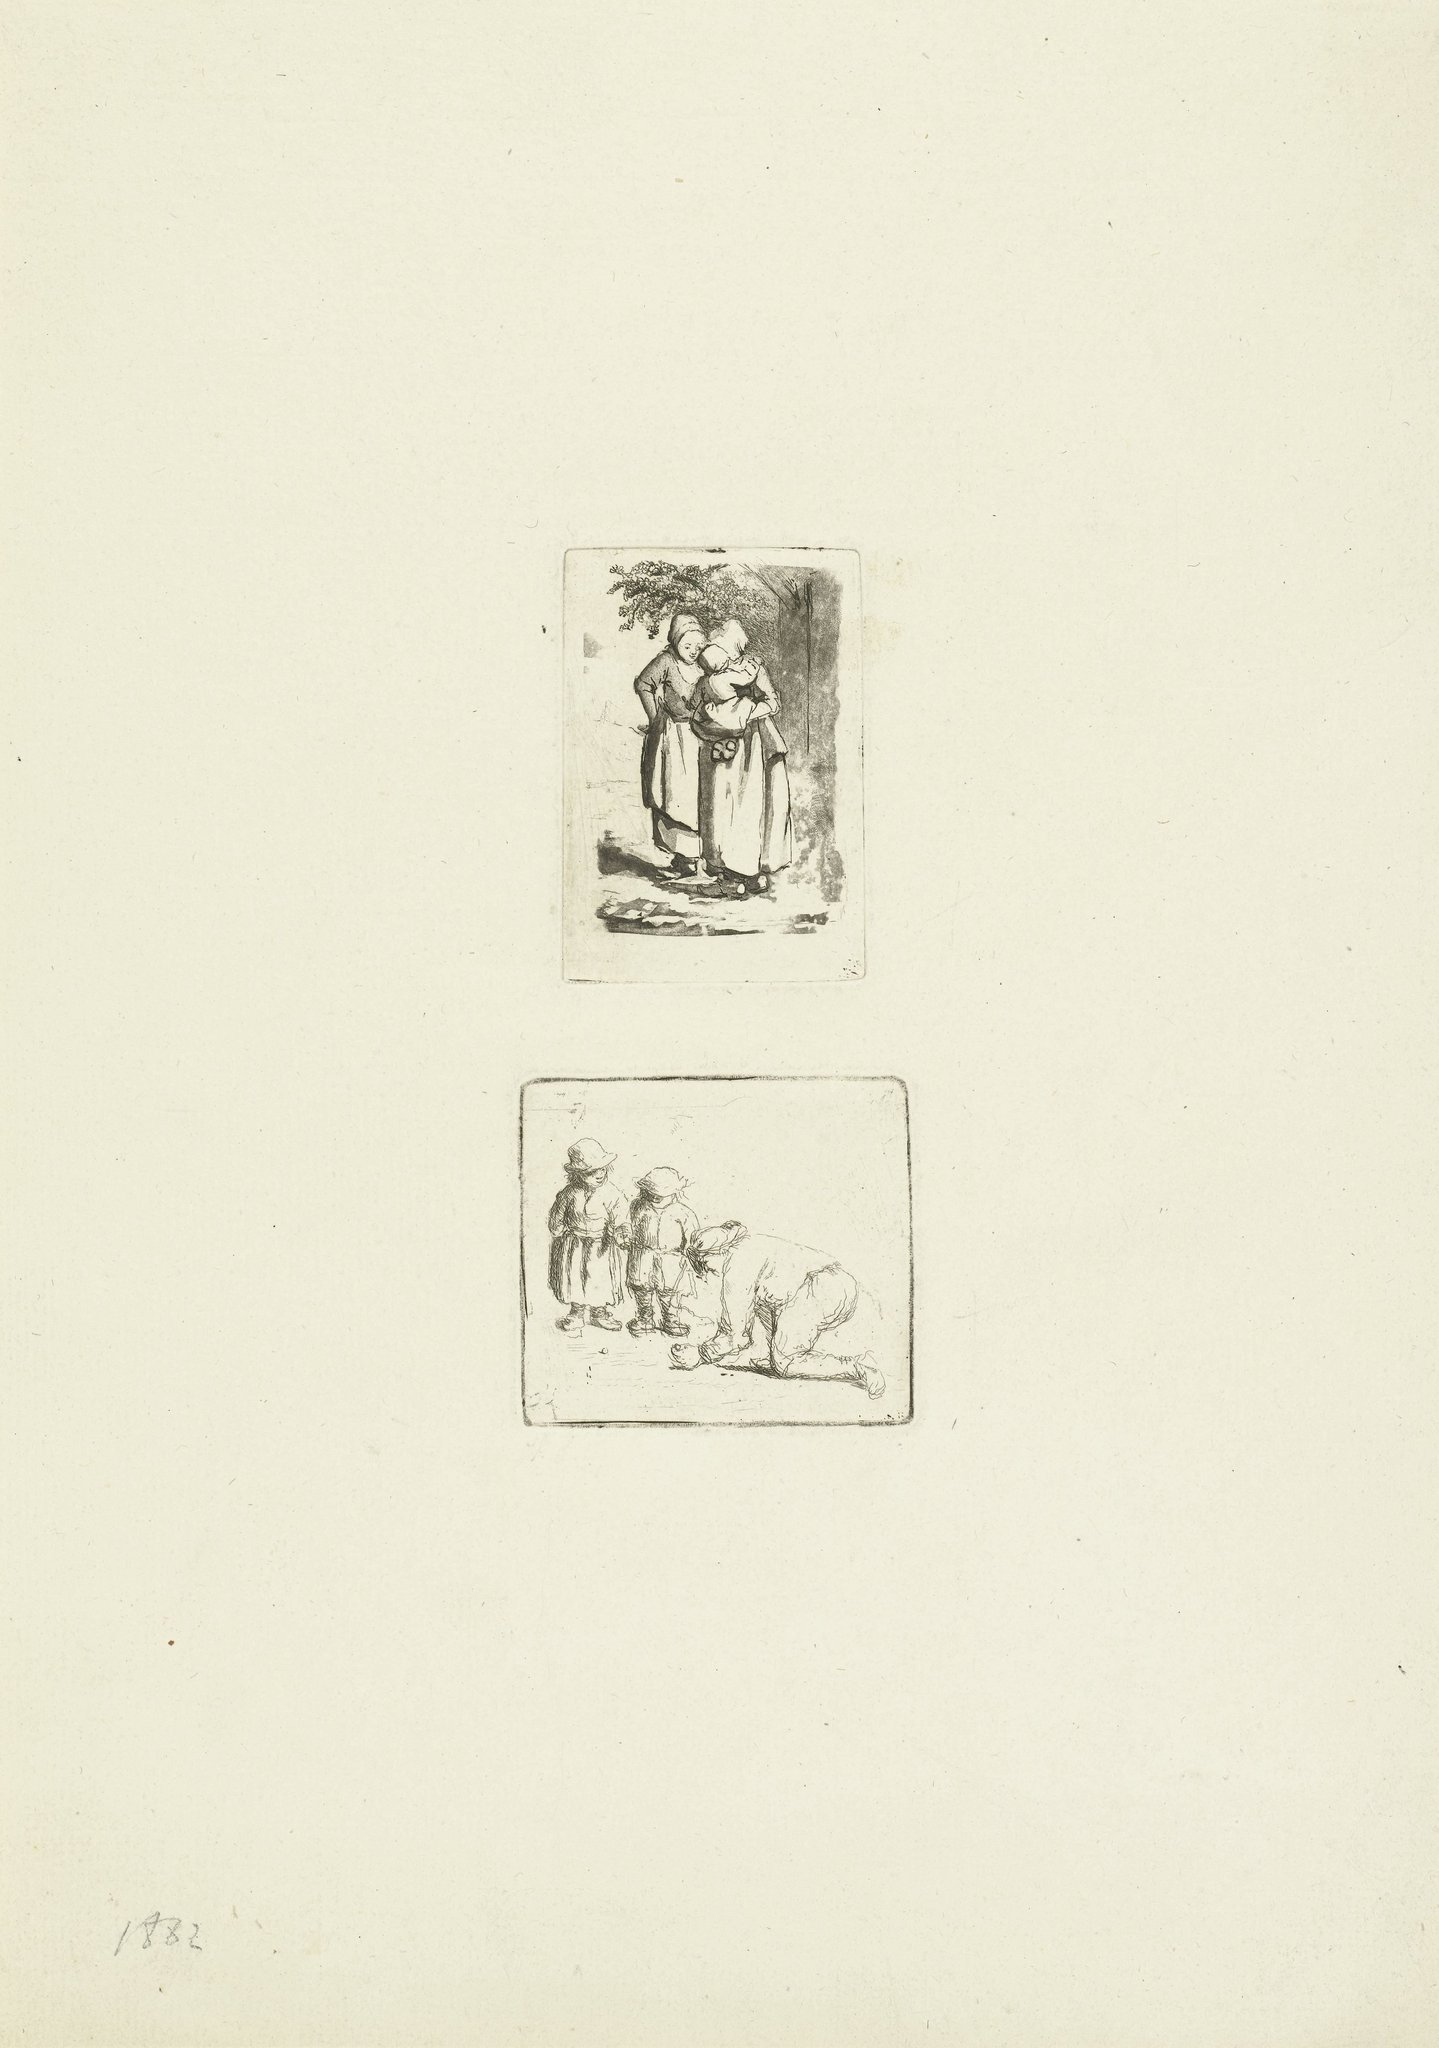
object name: print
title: Twee staande boerinnen, eentje met een kind op haar arm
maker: marie lambertine coclers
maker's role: conservator, draughtsman, print maker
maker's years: 1761-1815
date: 1776-1815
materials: paper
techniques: aquatint, drypoint, etching, roulette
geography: amsterdam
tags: mother and baby or young child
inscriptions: collector's mark: Lugt 2228